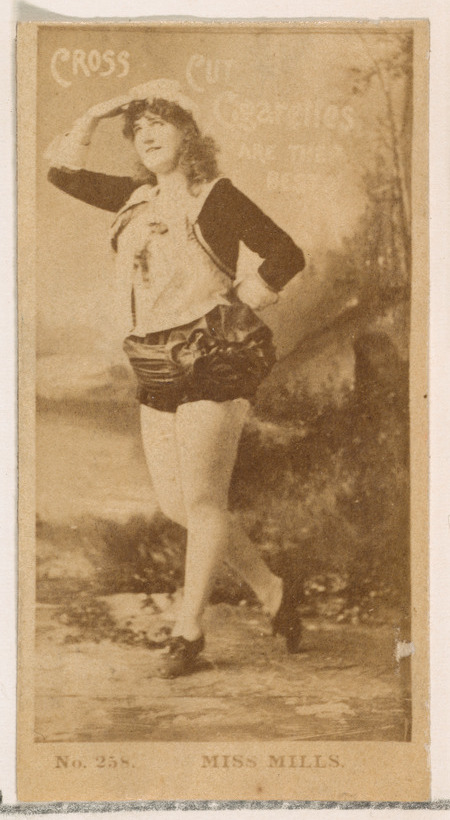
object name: print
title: Card Number 258, Miss Mills, from the Actors and Actresses series (N145-2) issued by Duke Sons & Co. to promote Cross Cut Cigarettes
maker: w. duke, sons & co.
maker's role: publisher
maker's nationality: american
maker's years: 1870-1920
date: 1880-1889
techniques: albumen silver print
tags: portraits,women,actresses